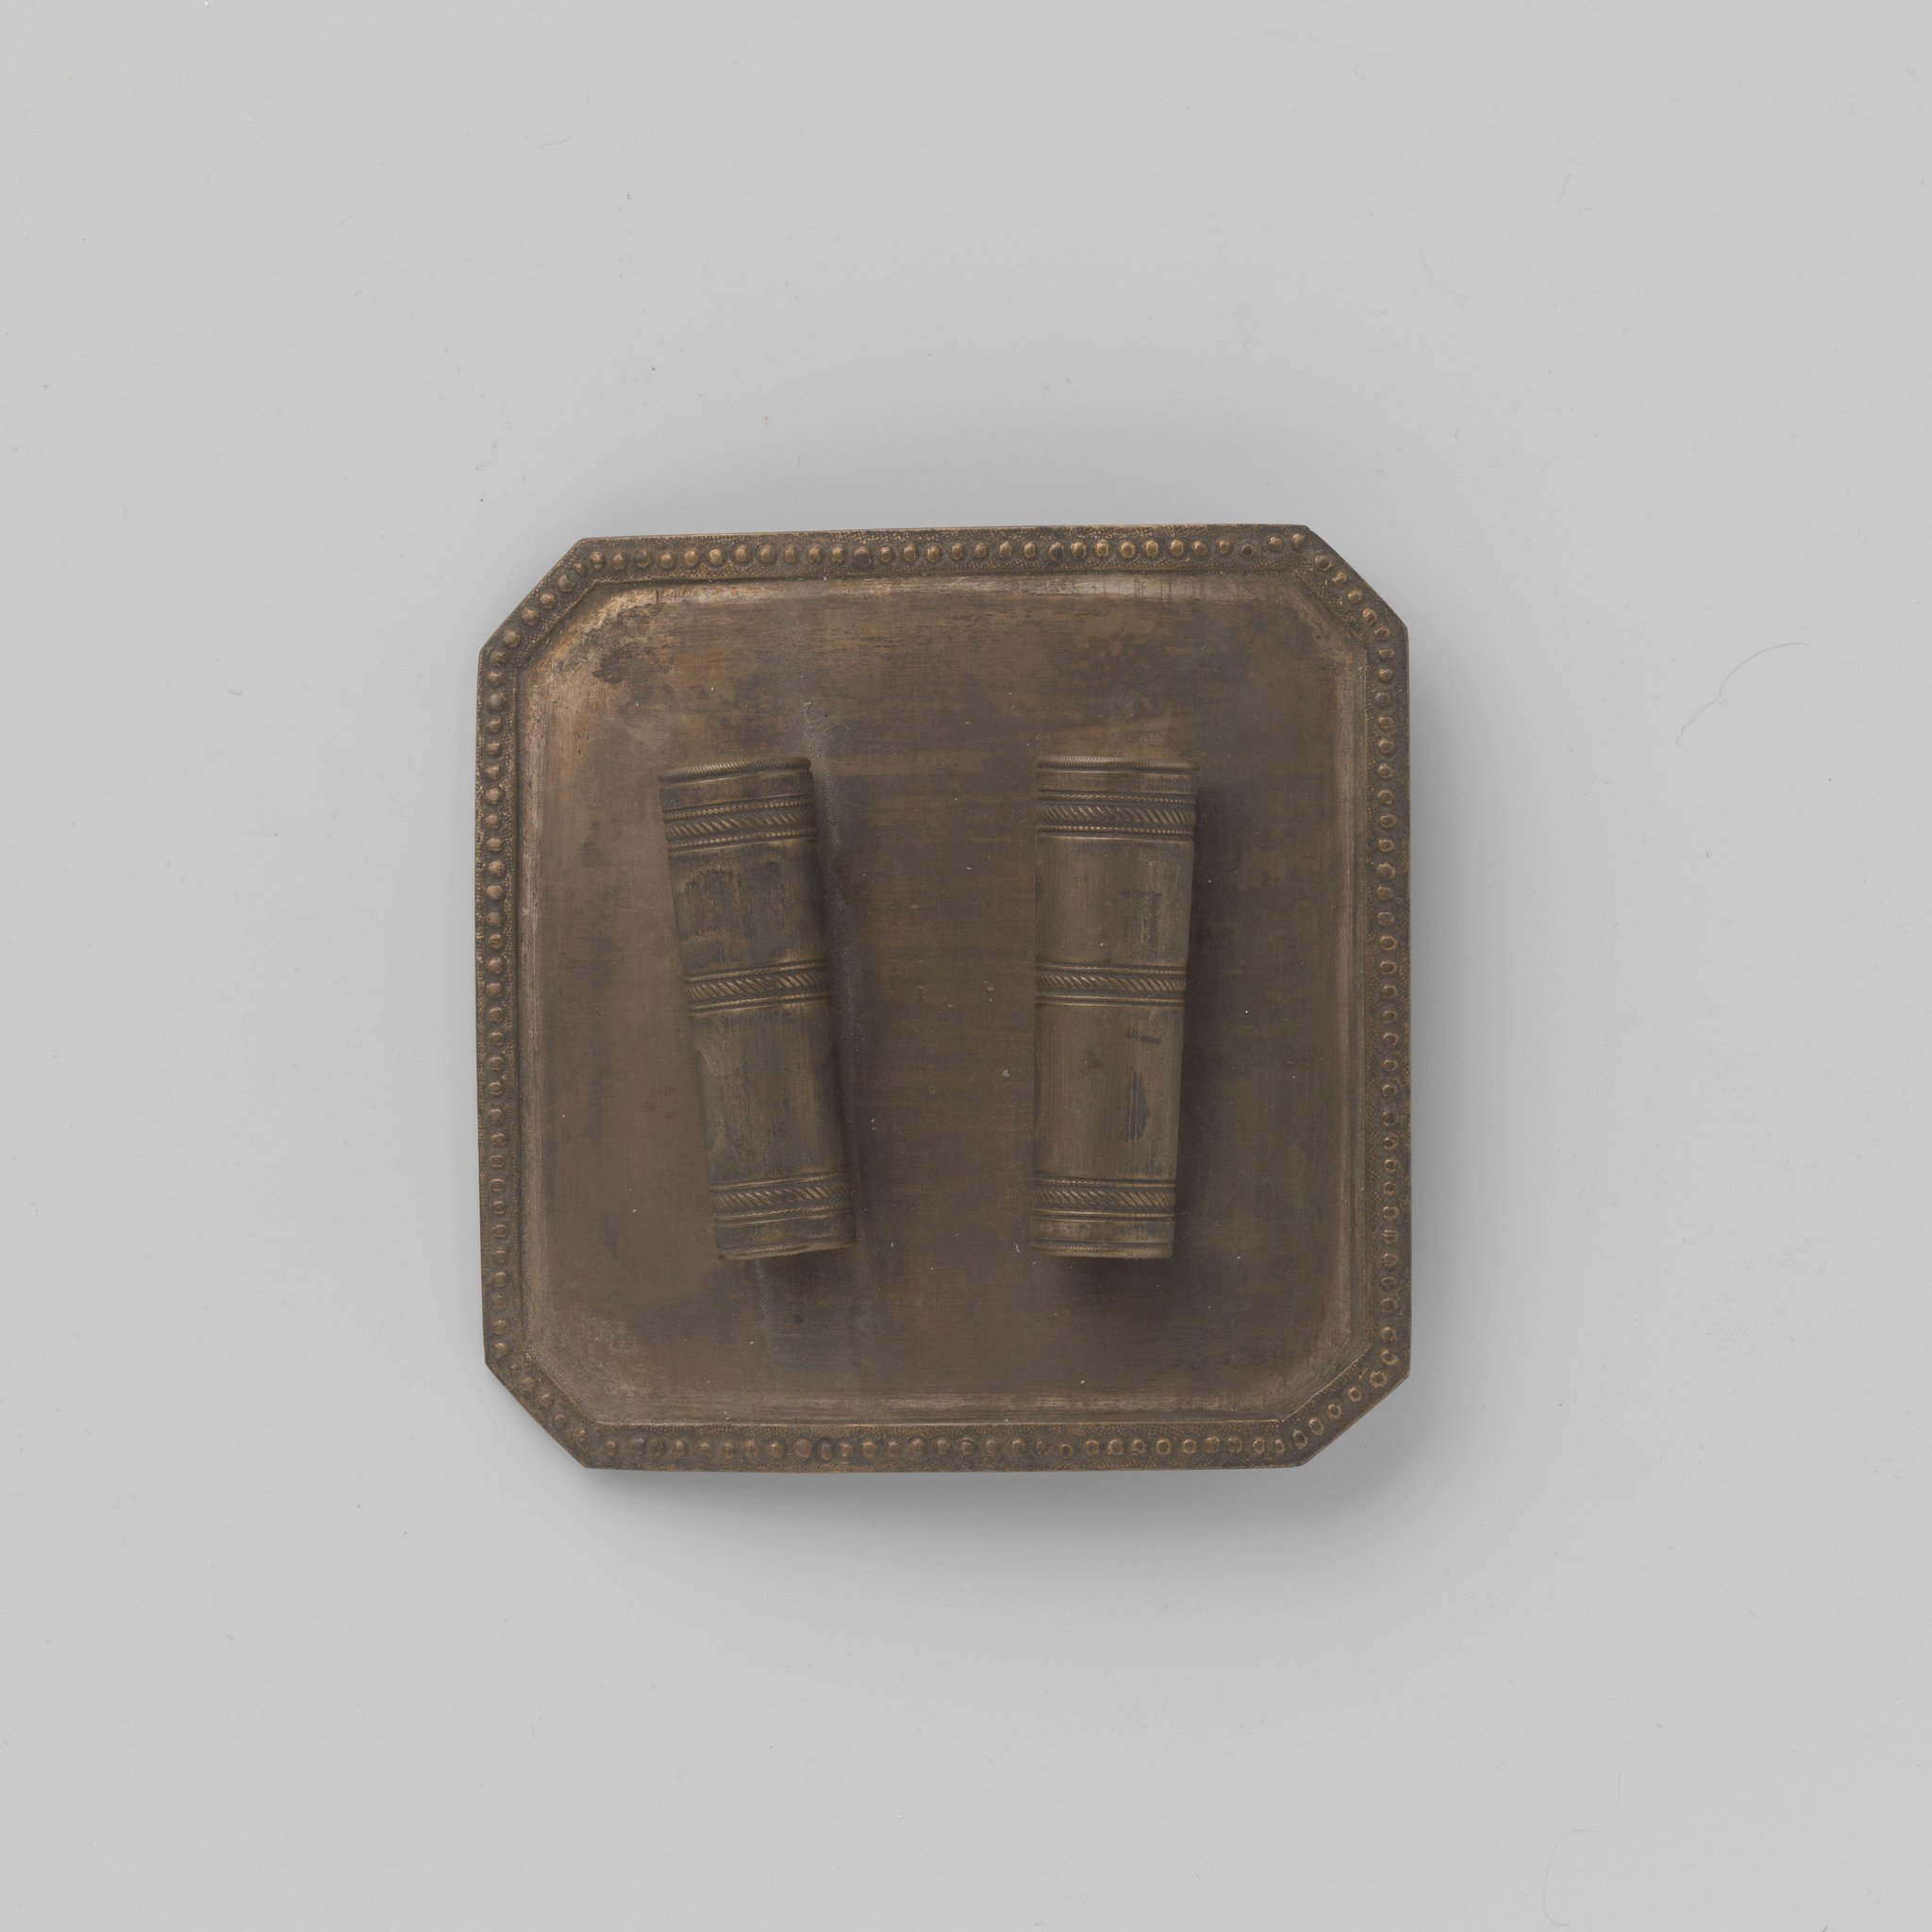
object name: element of musical instrument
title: Drumstick holder from a drummers belt plate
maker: Anonymous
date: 1823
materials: copper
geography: netherlands